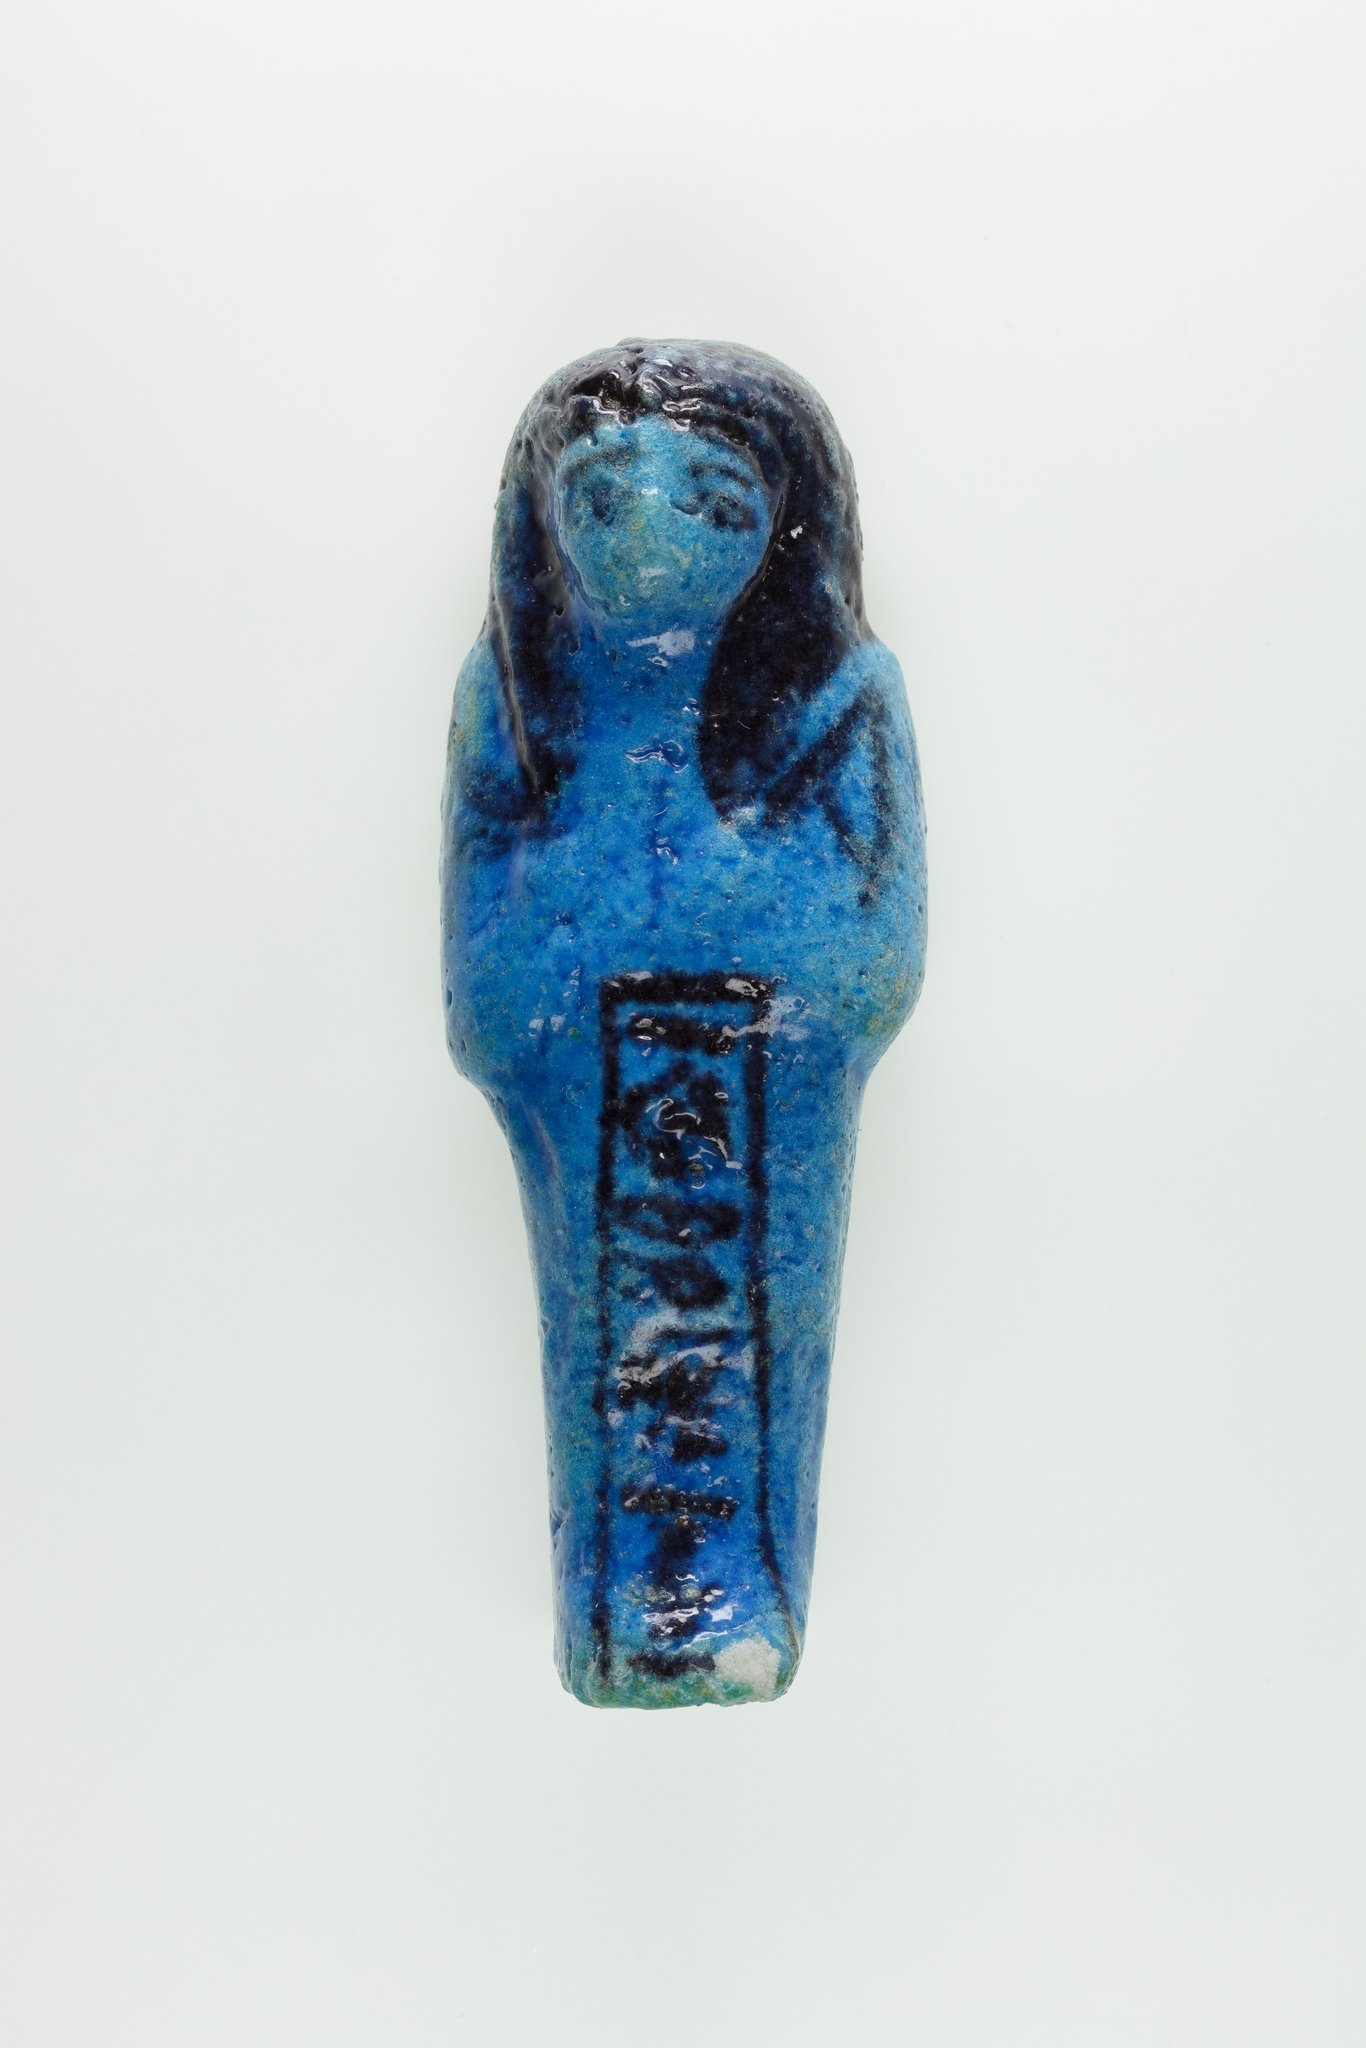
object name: shabti, worker, nauny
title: Worker Shabti of Nauny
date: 1050 BCE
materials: faience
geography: egypt